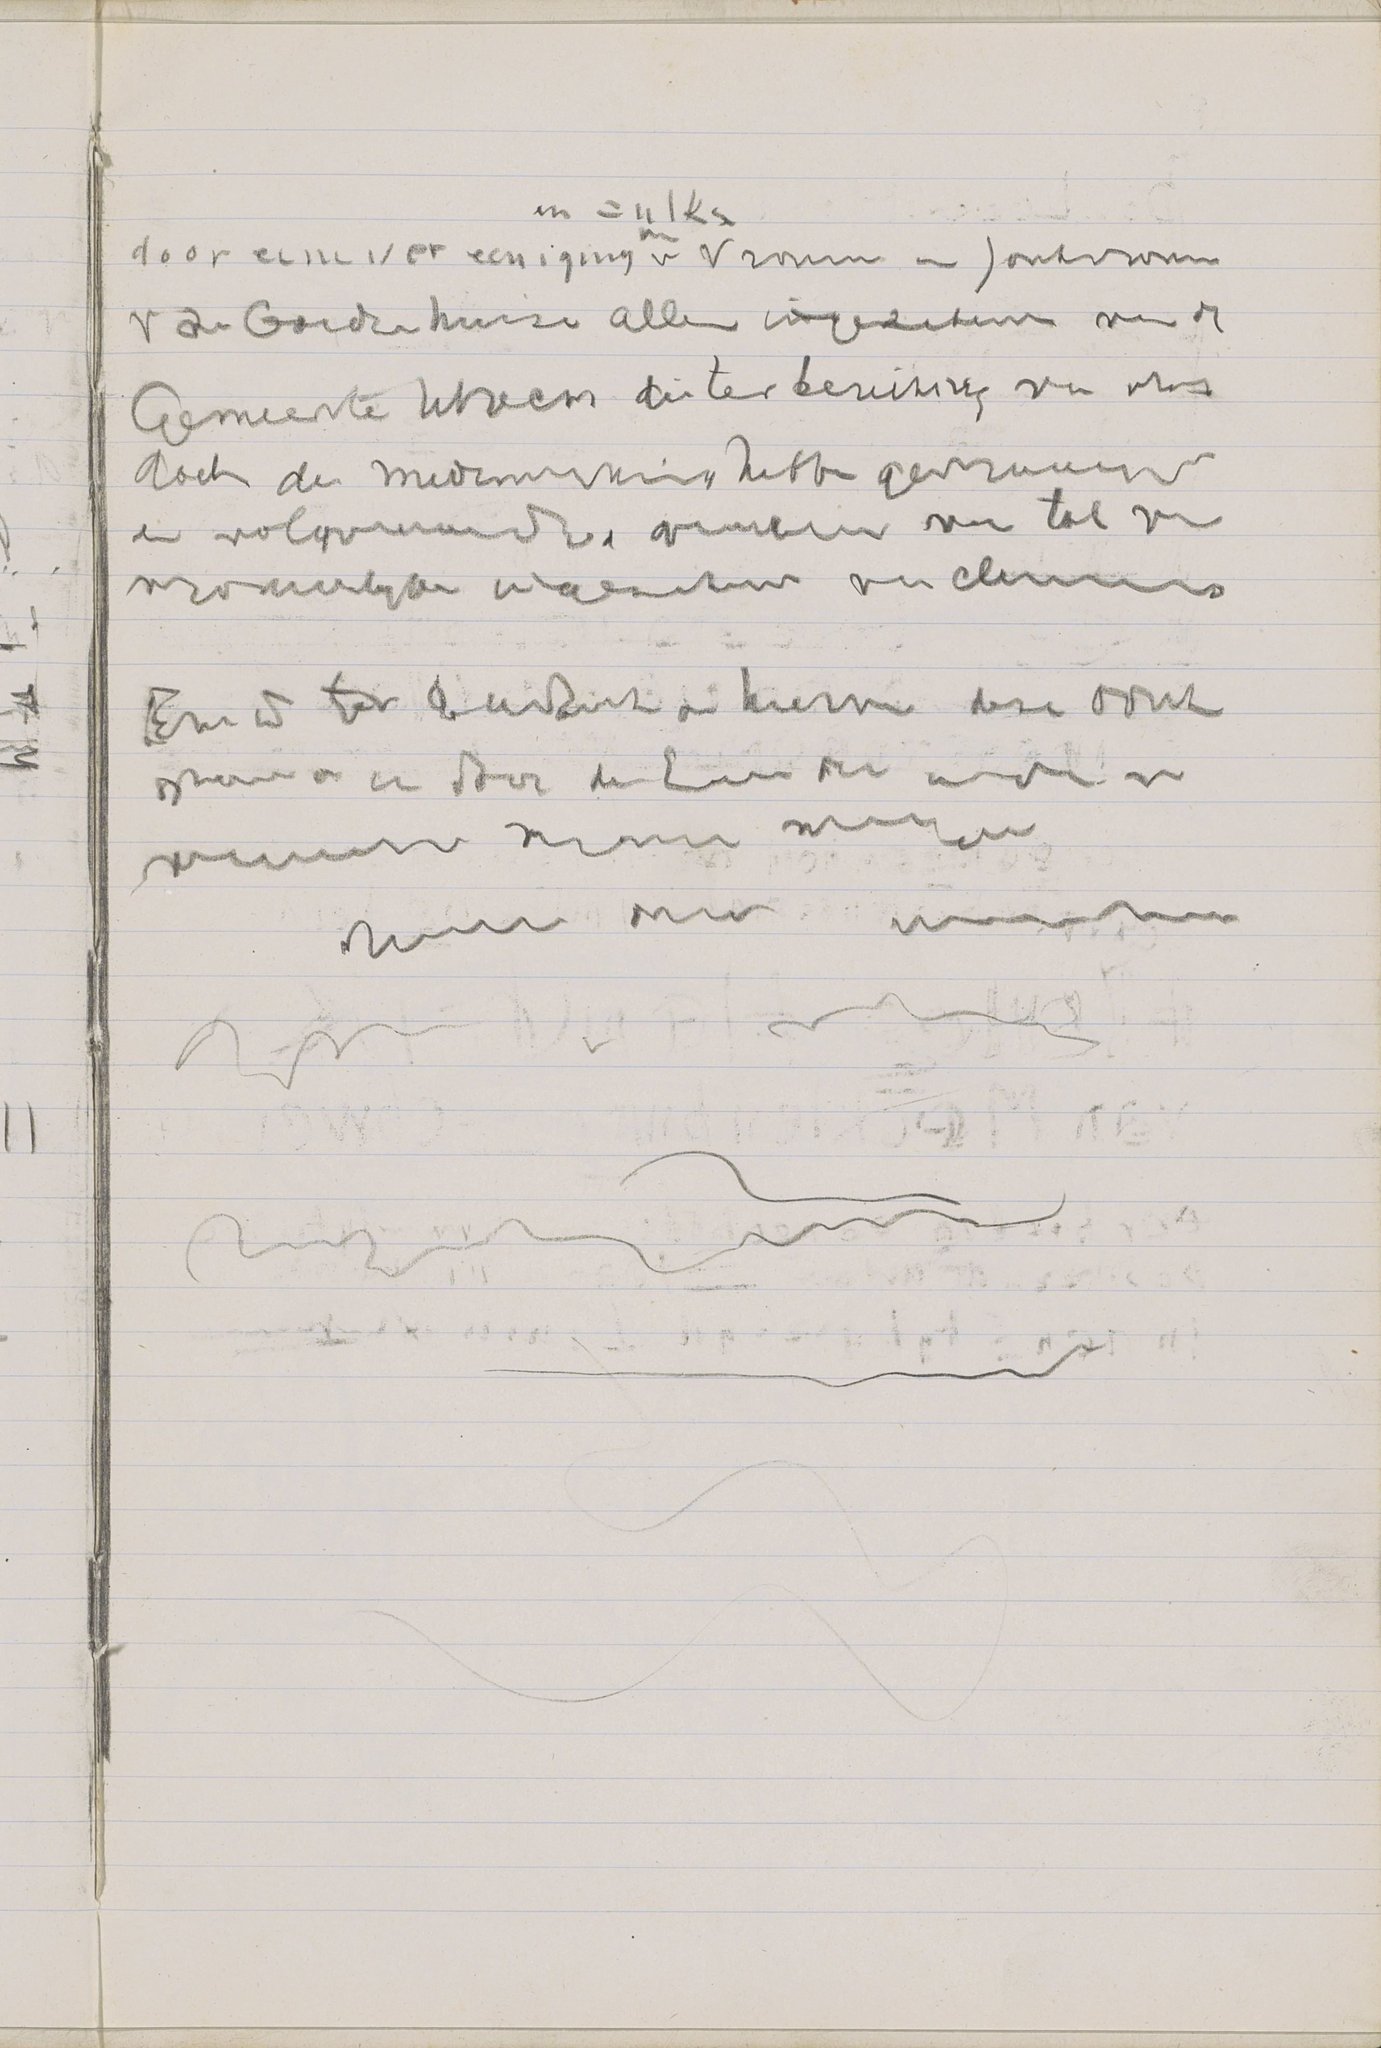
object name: sketchbook leaf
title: Notities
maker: gerrit willem dijsselhof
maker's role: designer, draughtsman, print maker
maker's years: 1866-1924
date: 1901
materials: chalk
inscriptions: annotation: ‘[...]/ door eene vereeniging v vrouw[...] jonkrvrouw/ van goede huize alle[...] ingezetenen [...]’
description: Blad 51 recto uit een schetsboek met 79 bladen.